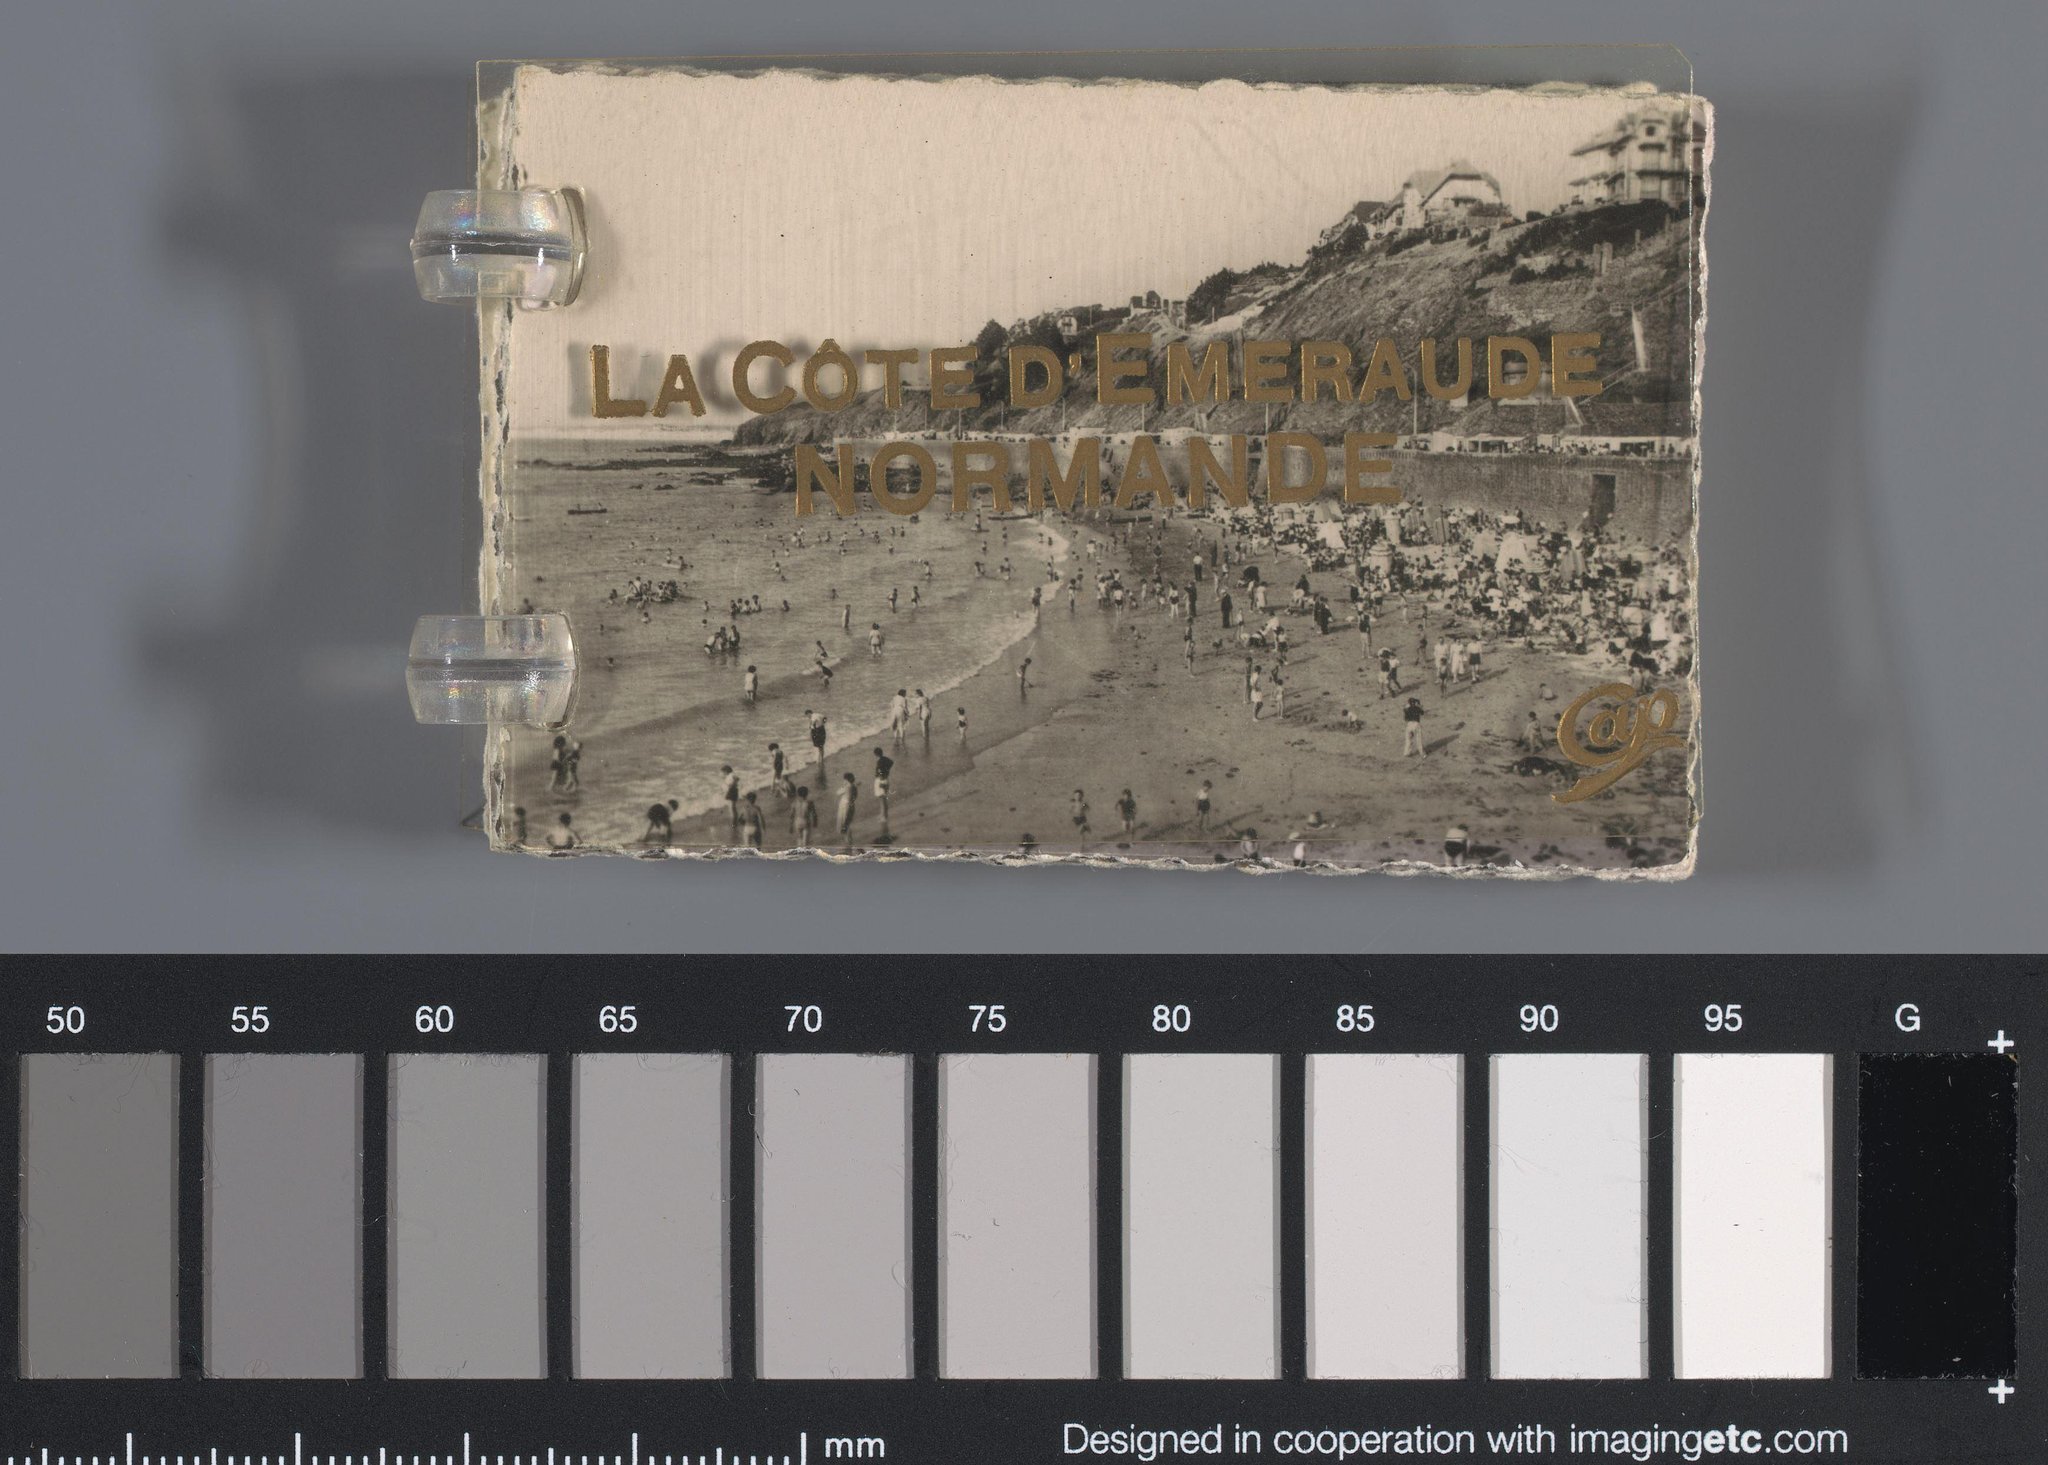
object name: carte de visite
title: Souvenirboekje La Côte d’Emaraude Normande, met 12 foto’s van o.a. het strand en Mont St-Michel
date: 1950-1960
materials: paper, photographic support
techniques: gelatin silver print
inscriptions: : ‘LA CÔTE D’EMERAUDE / NORMANDE’, : ‘Babycap / de la / Cie des Arts Photomécanques / 44, rue Letellier, 44 / PARIS / (15e)’